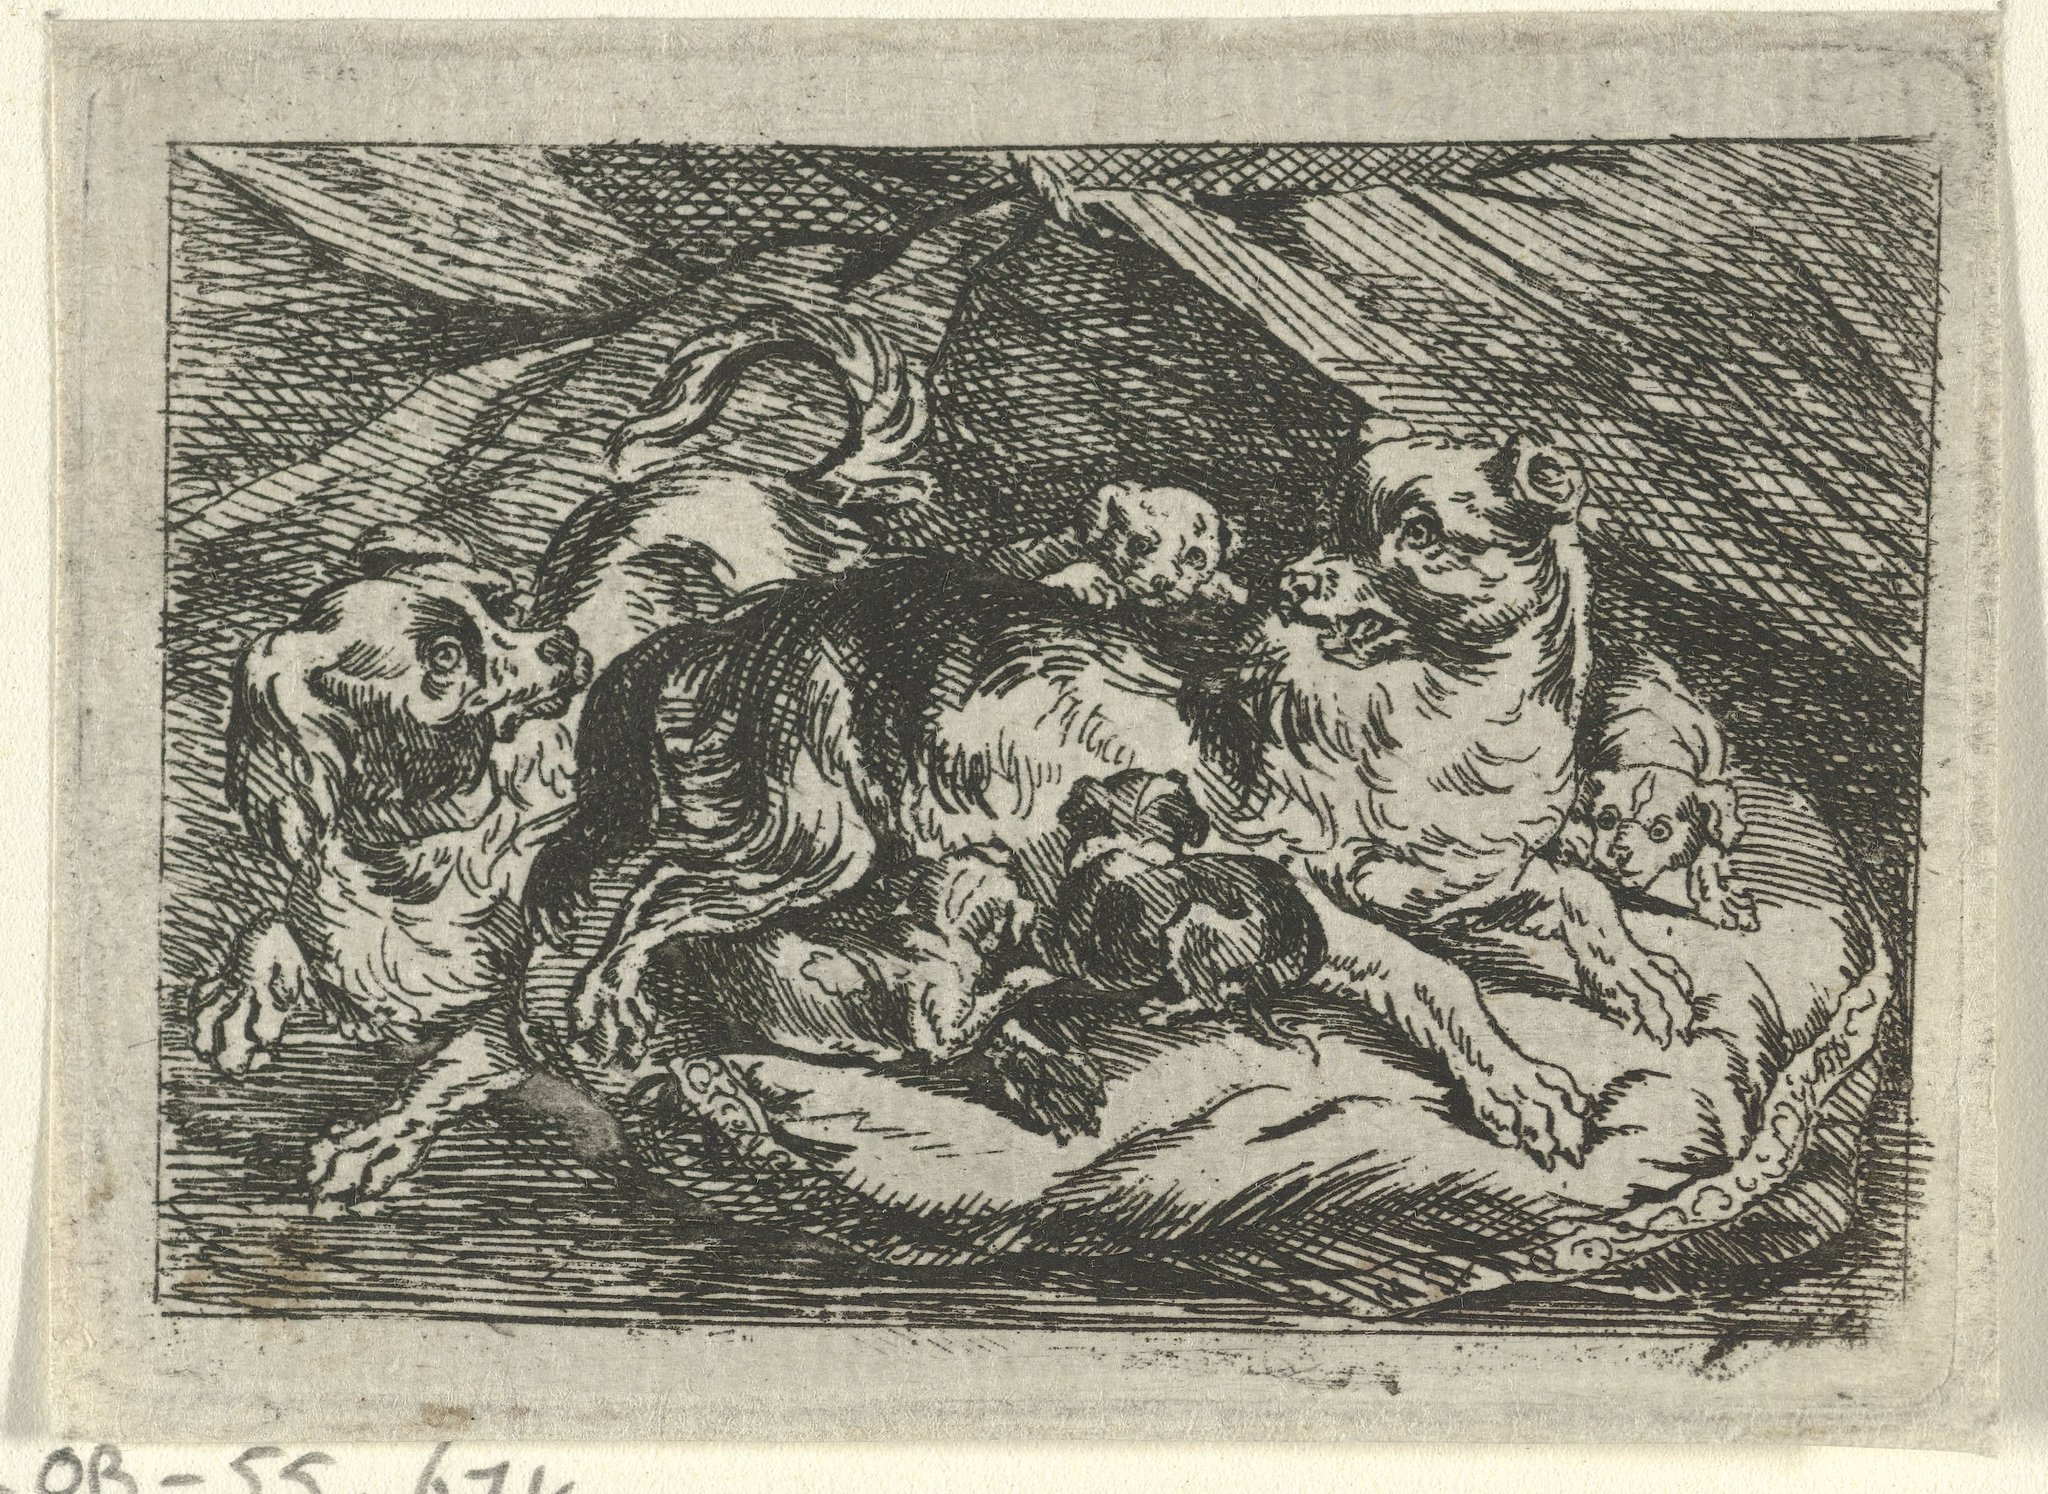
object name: print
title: Nest met jonge hondjes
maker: tethart philip christian haag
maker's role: draughtsman, print maker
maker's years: 1737-1812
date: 1747-1812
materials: paper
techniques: etching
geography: the hague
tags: dog, dog (+ young animal)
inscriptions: collector's mark: Lugt 240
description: Een mand met daarin een nest met vier jonge hondjes, de moeder en de vader.